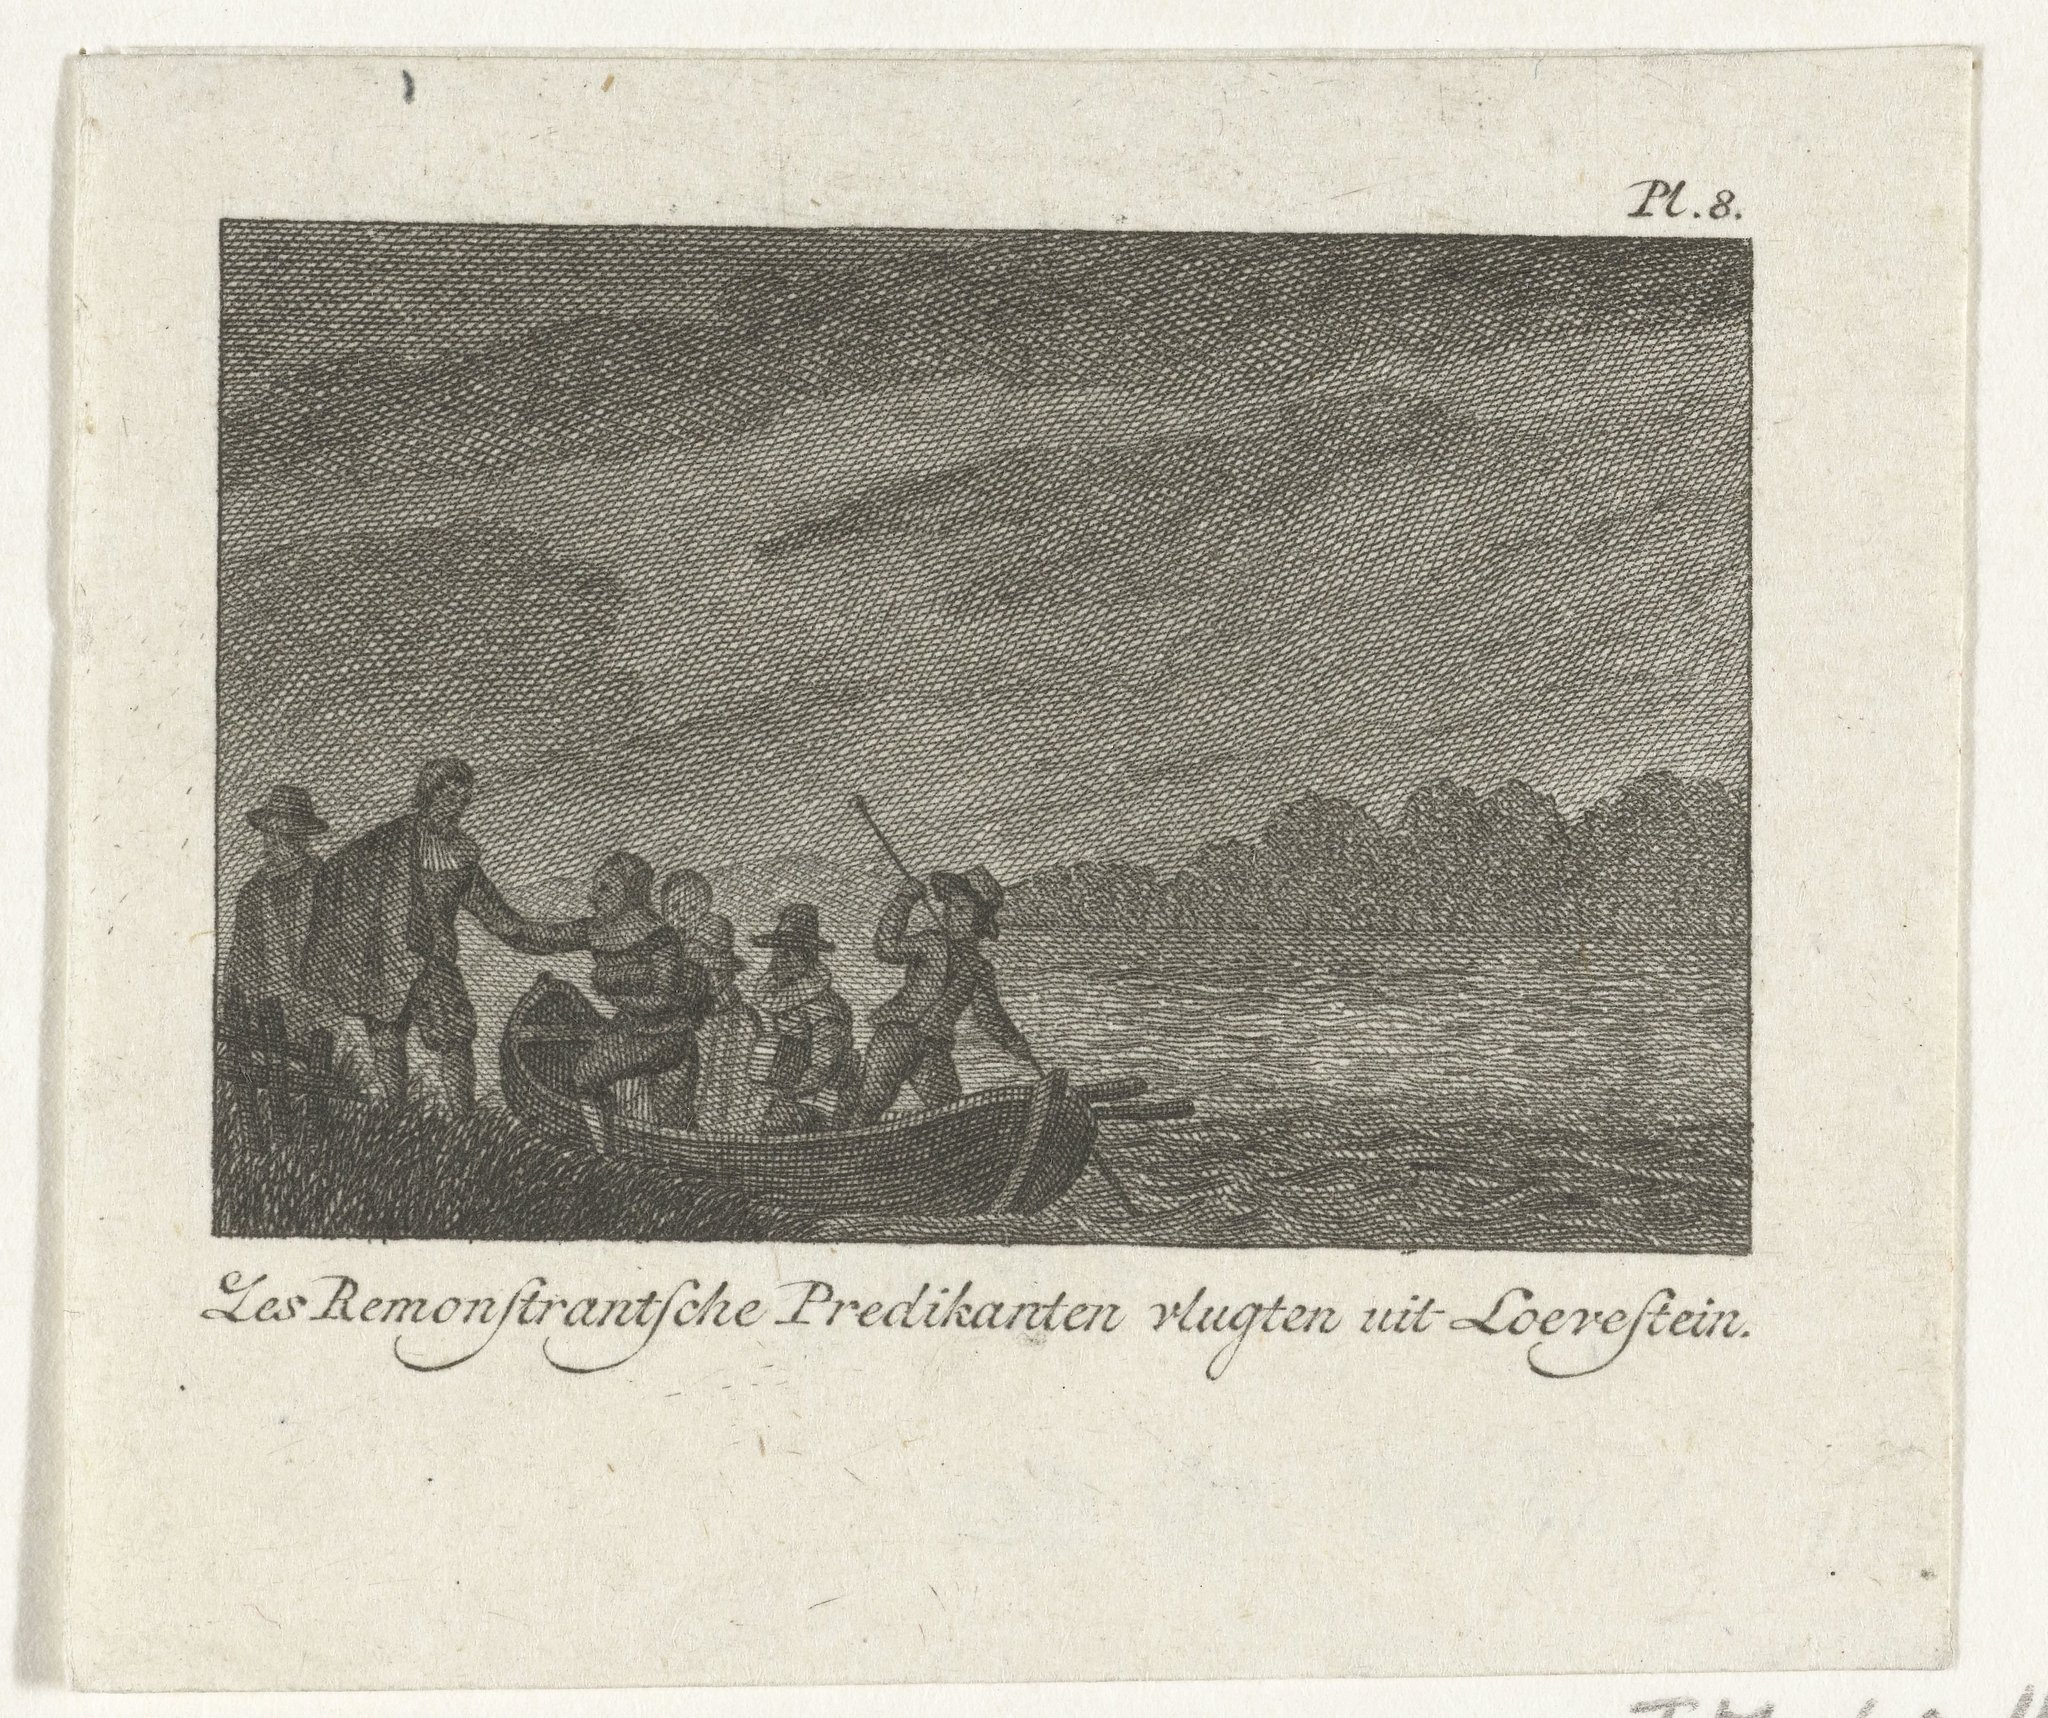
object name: print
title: Ontsnapping van de zeven remonstrantse predikanten uit slot Loevestein, 1631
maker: Anonymous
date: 1775-1799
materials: paper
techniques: etching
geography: northern netherlands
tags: law and jurisprudence (+ escape from prison), loevestein castle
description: De ontsnapping van de zeven remonstrantse predikanten uit slot Loevestein, 's nachts in een roeibootje, 19 juli 1631. Gemerkt rechtsboven: Pl. 8.